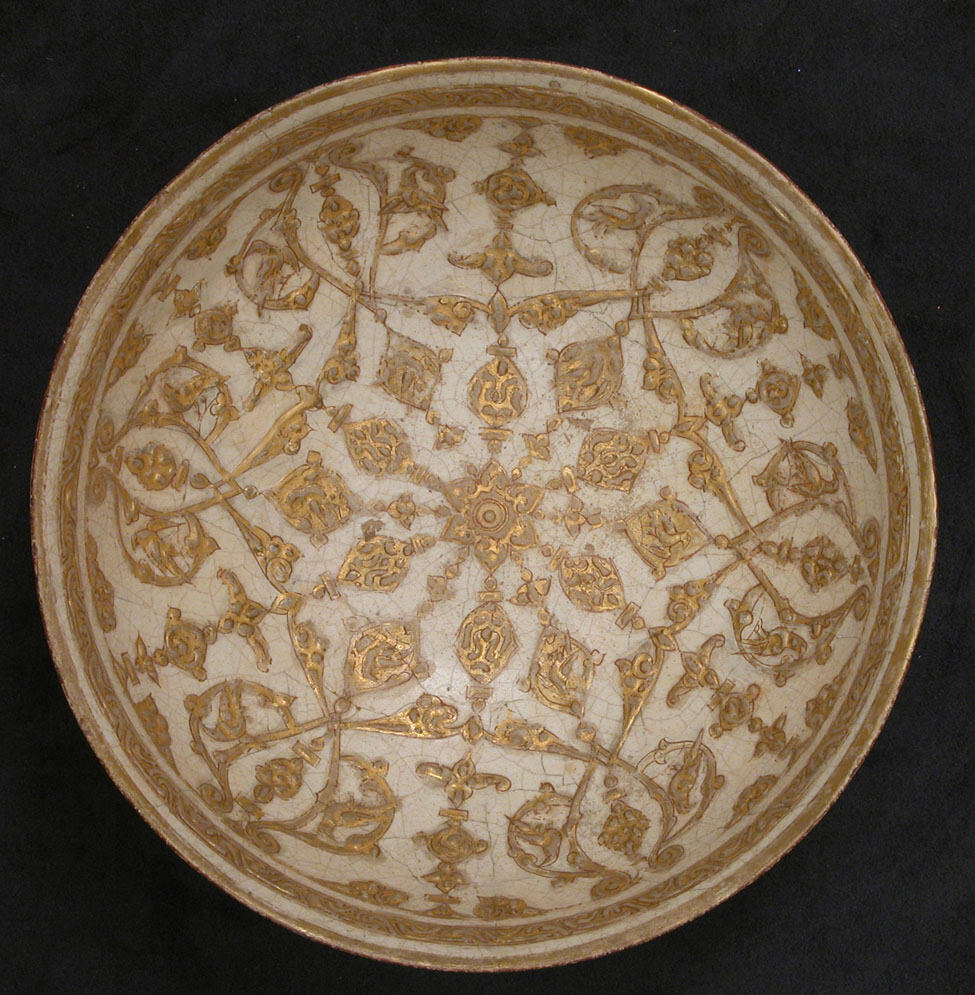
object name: bowl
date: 1101-1300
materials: glaze, stonepaste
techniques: gilding, overglaze, painting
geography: iran